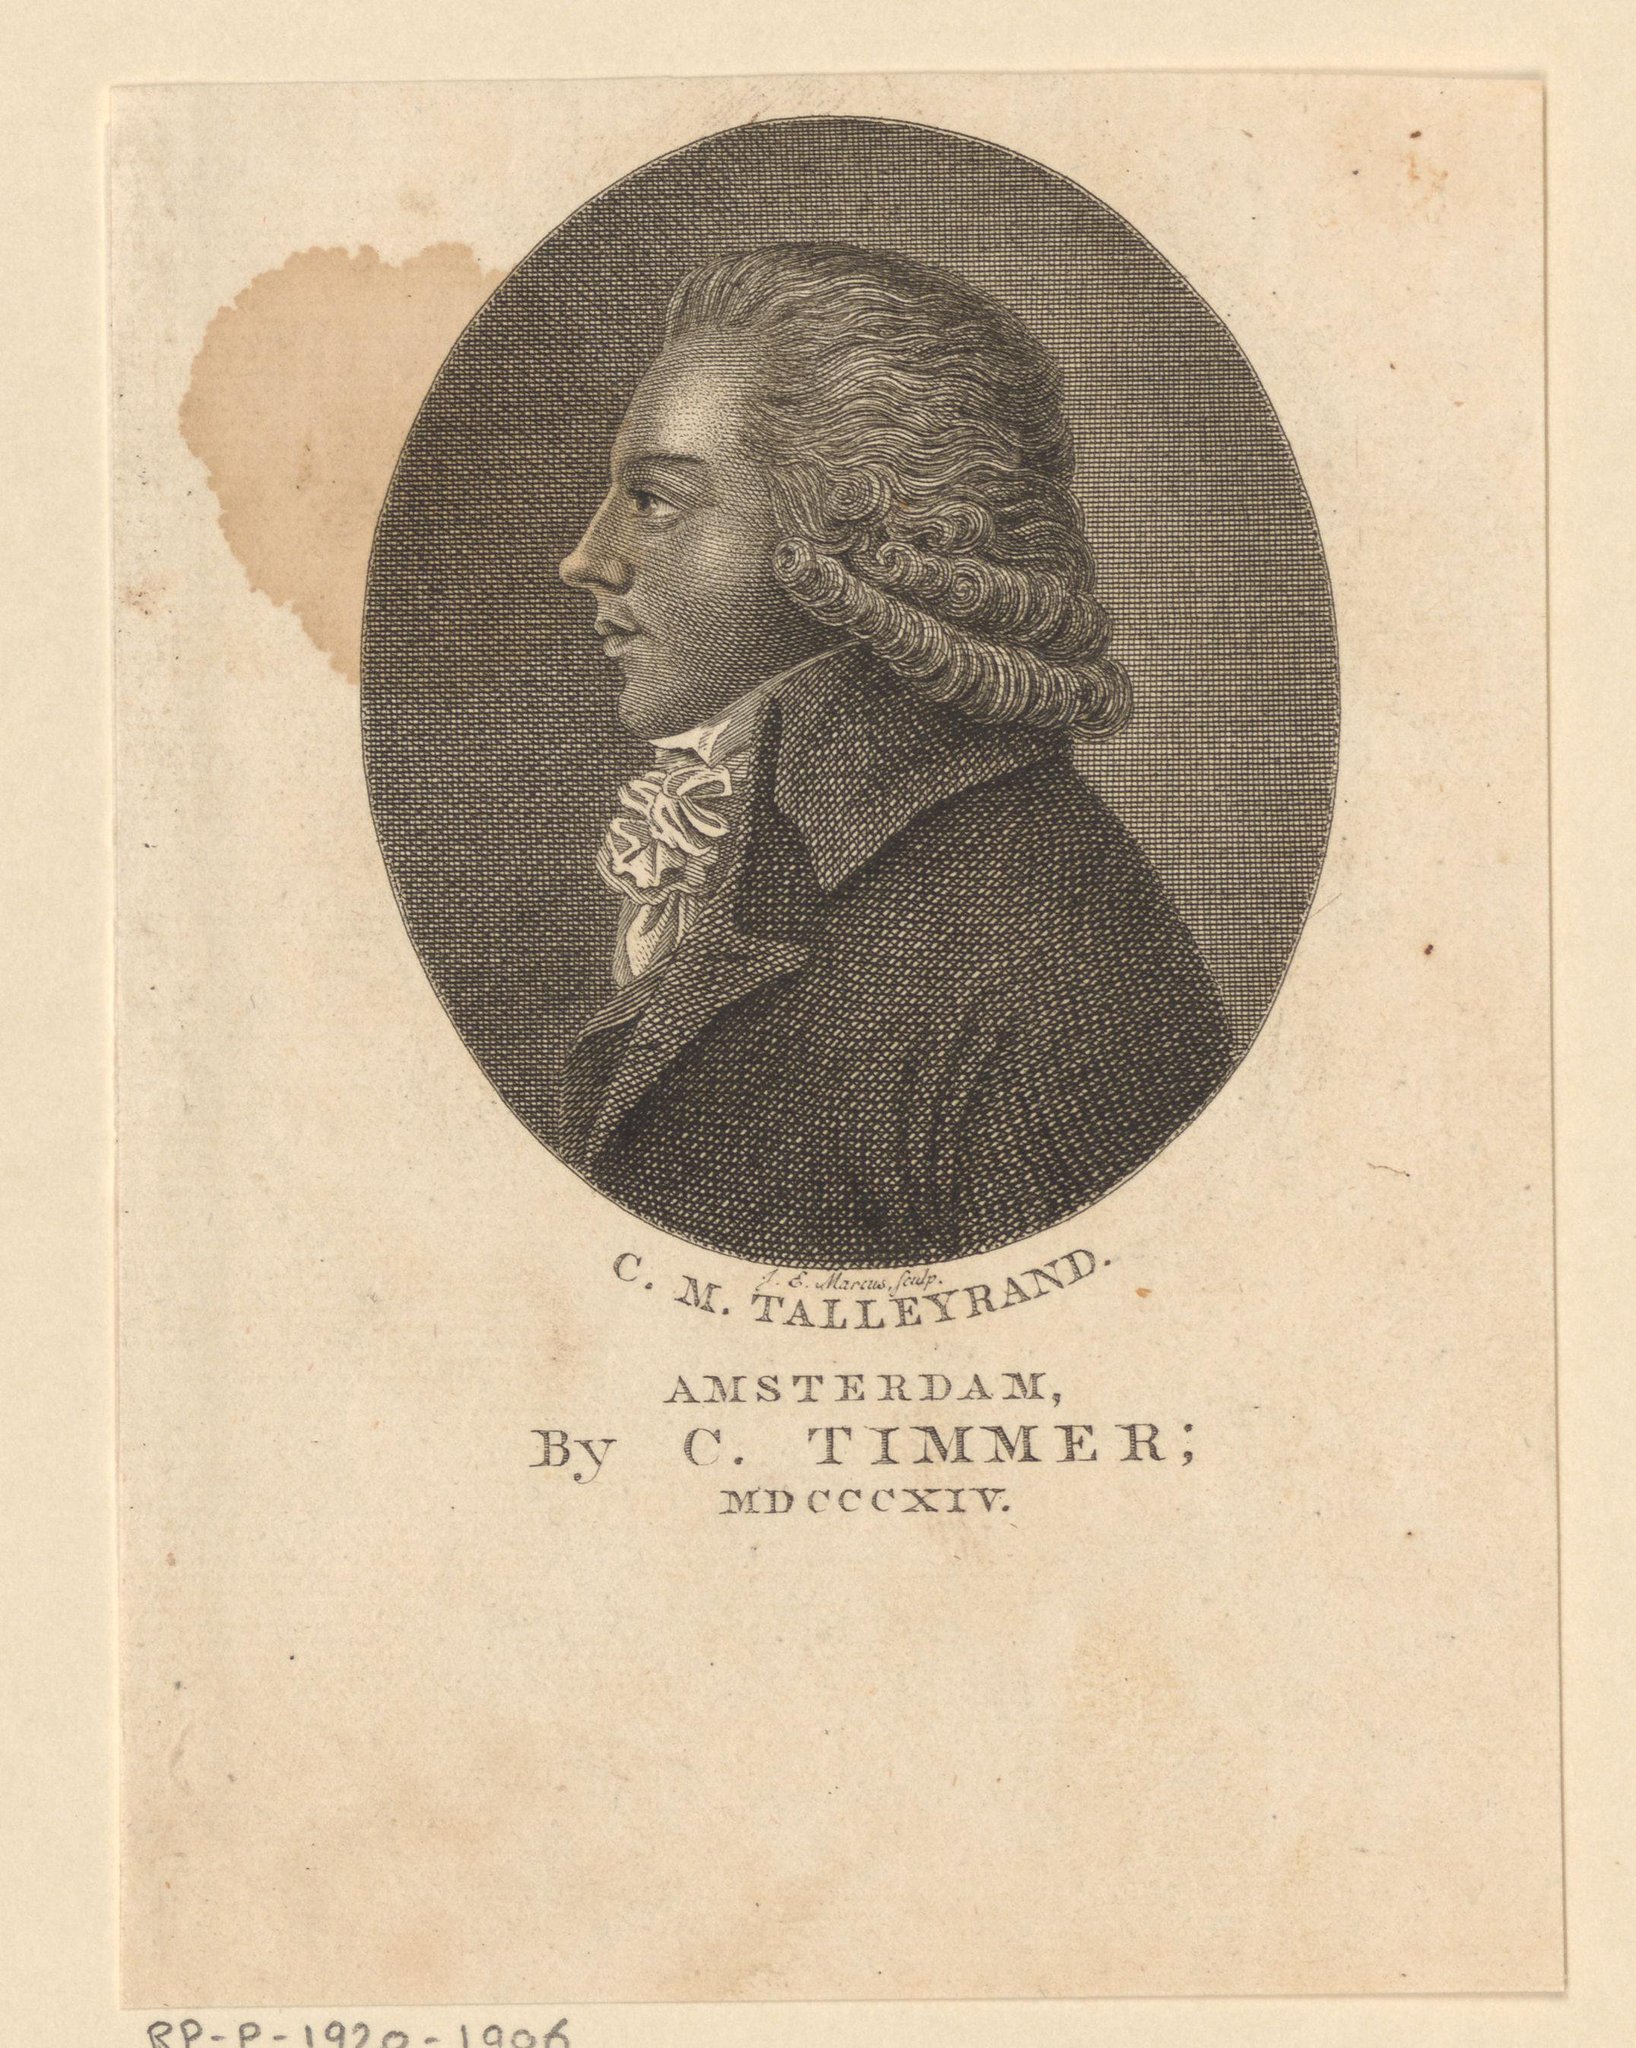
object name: print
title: Titelpagina voor: C.M. de Talleyrand-Périgord, Gedenkschriften, 1814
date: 1814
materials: paper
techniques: etching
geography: amsterdam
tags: politician, charles maurice hertog van talleyrand-périgord, historical persons, politician, e.g. party leader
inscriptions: collector's mark: Lugt 2228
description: Titelpagina voor: Talleyrand-Périgord, Charles Maurice de. Gedenkschriften van C.M. Talleyrand de Perigord (...). Amsterdam: Cornelis Timmer, 1814.